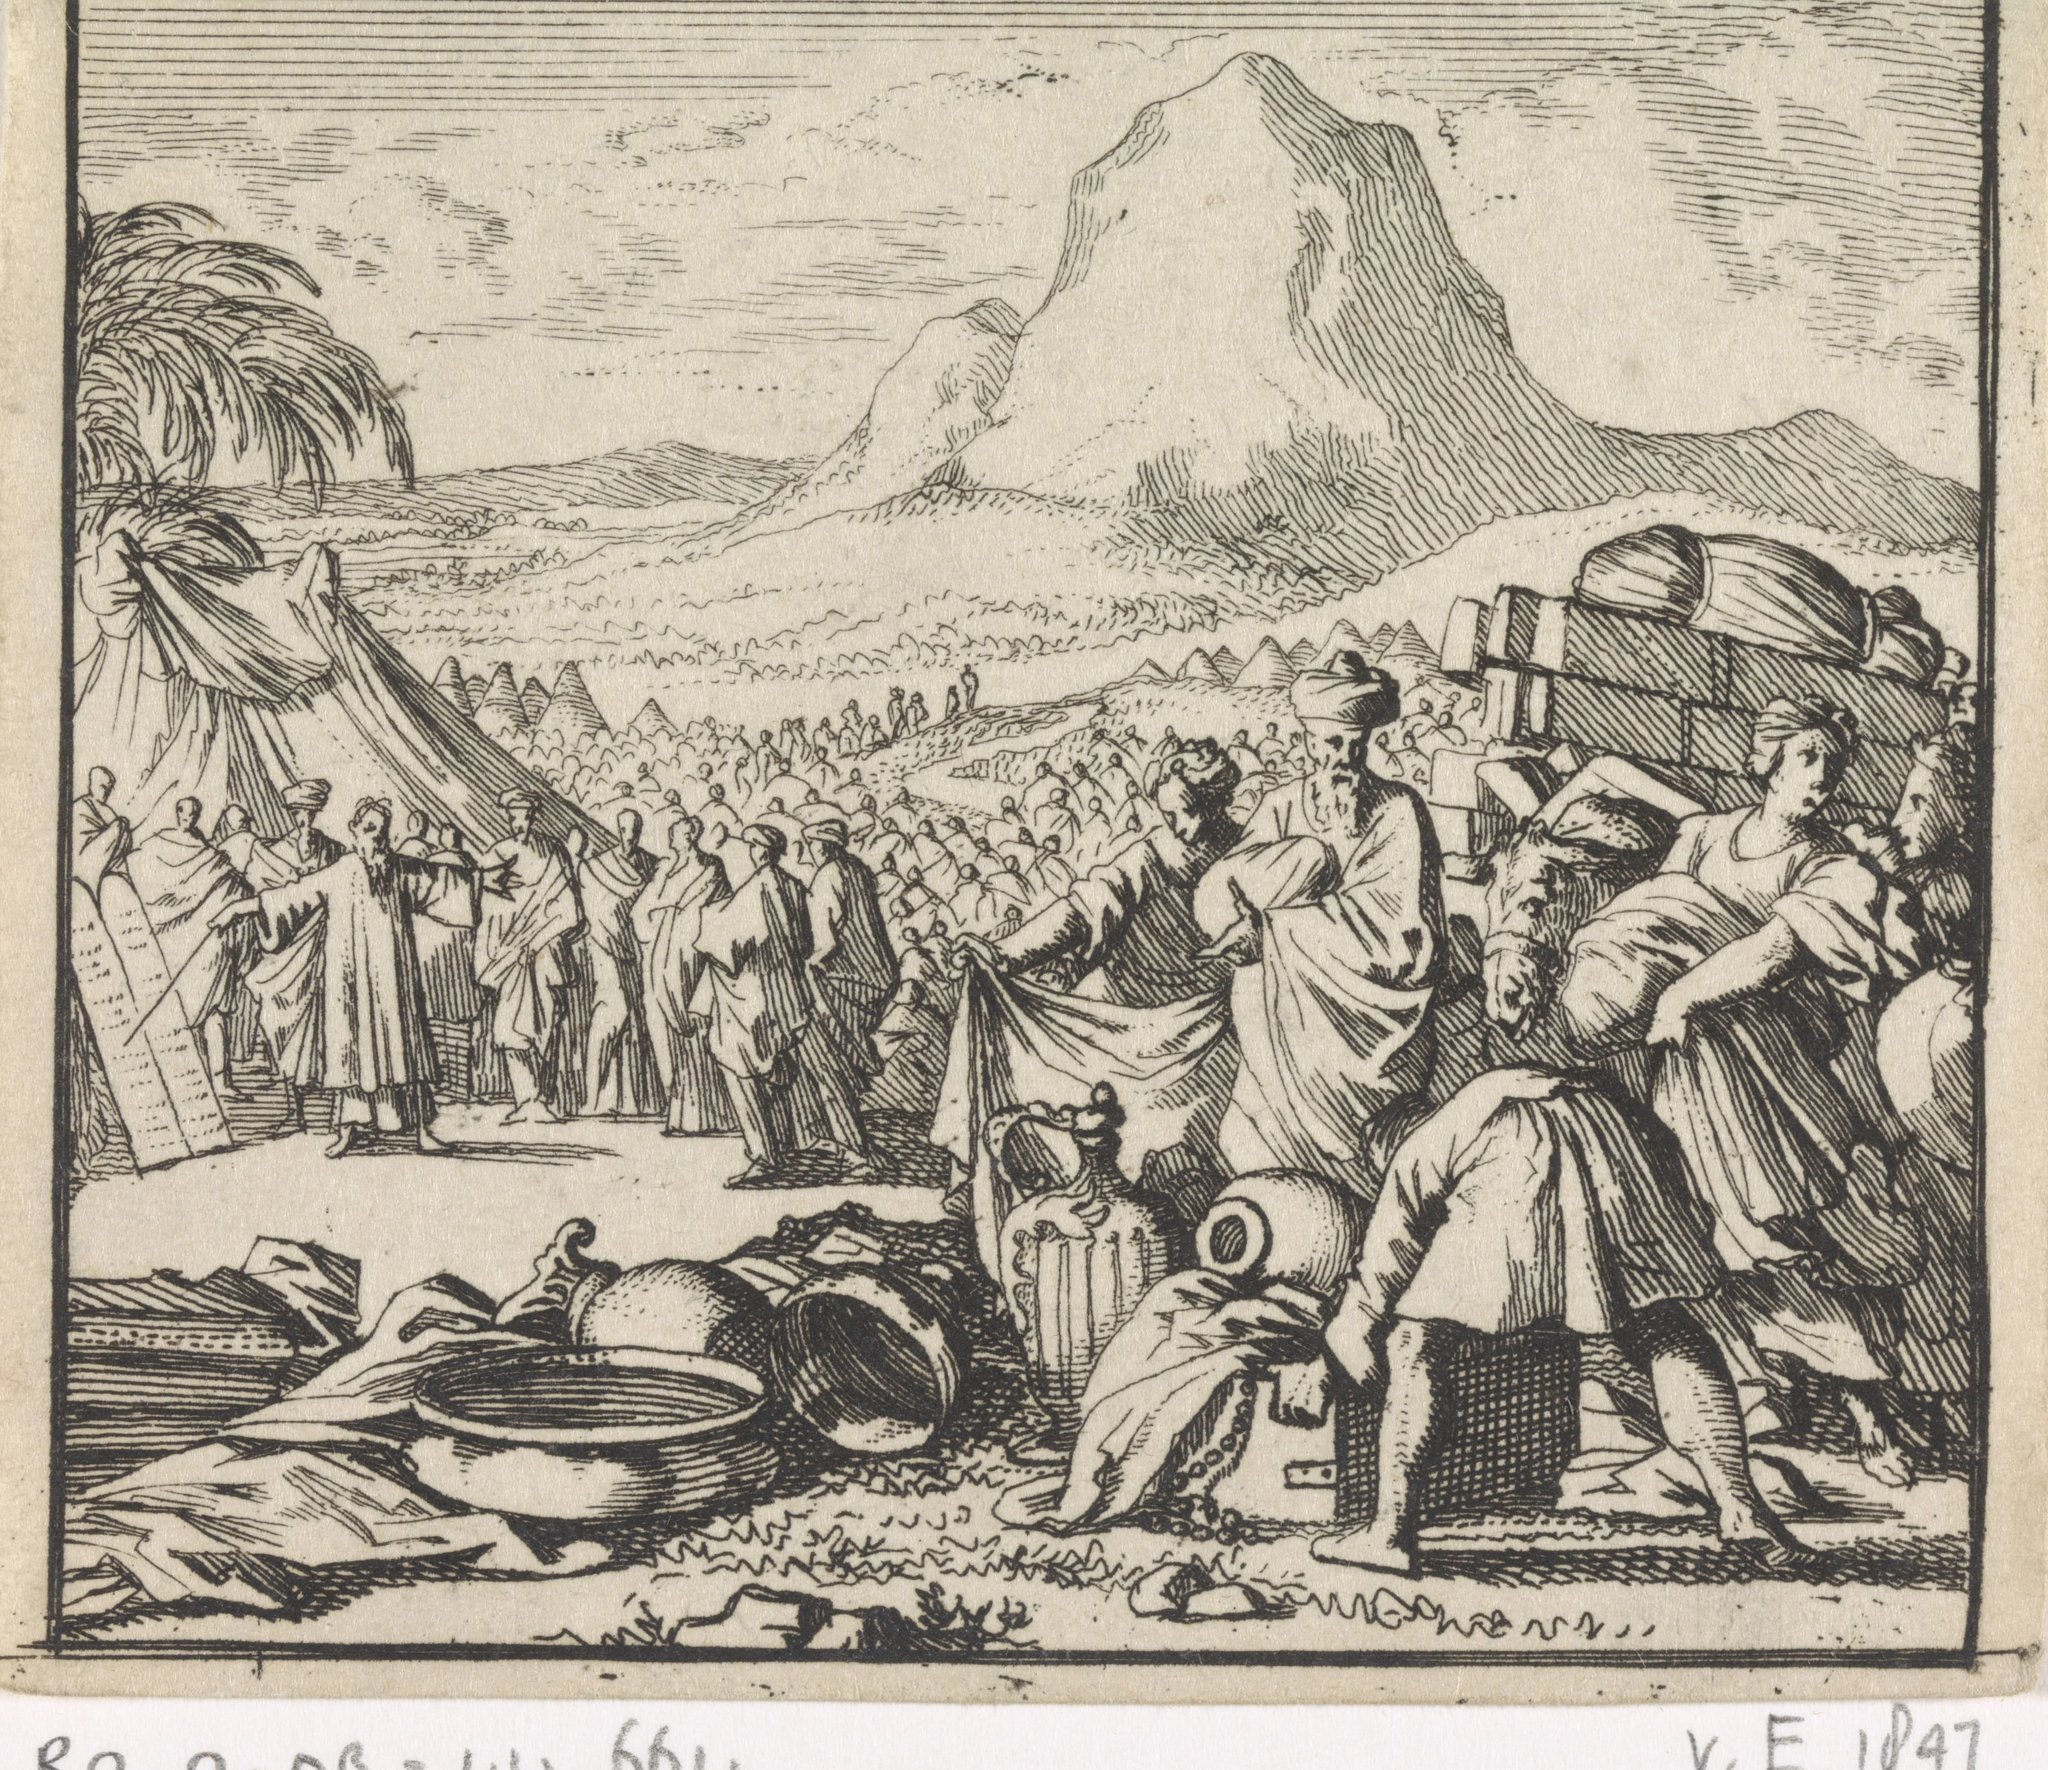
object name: print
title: Mozes legt de oudsten de tien geboden uit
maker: caspar luyken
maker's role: draughtsman, print maker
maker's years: 1672-1708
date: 1698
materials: paper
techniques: etching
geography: amsterdam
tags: moses on mount sinai with the tables of the law (exodus 24:9-18, 31:18)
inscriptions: collector's mark: Lugt 2228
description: Proefdruk van illustratie uit: Josephus, Flavius. XX. boeken van de oude geschiedenissen der joden, 4 delen. Amsterdam: Barent Visscher, Willem de Coup, Willem van Lamsveld, Andries van Damme, 1698, dl. I.